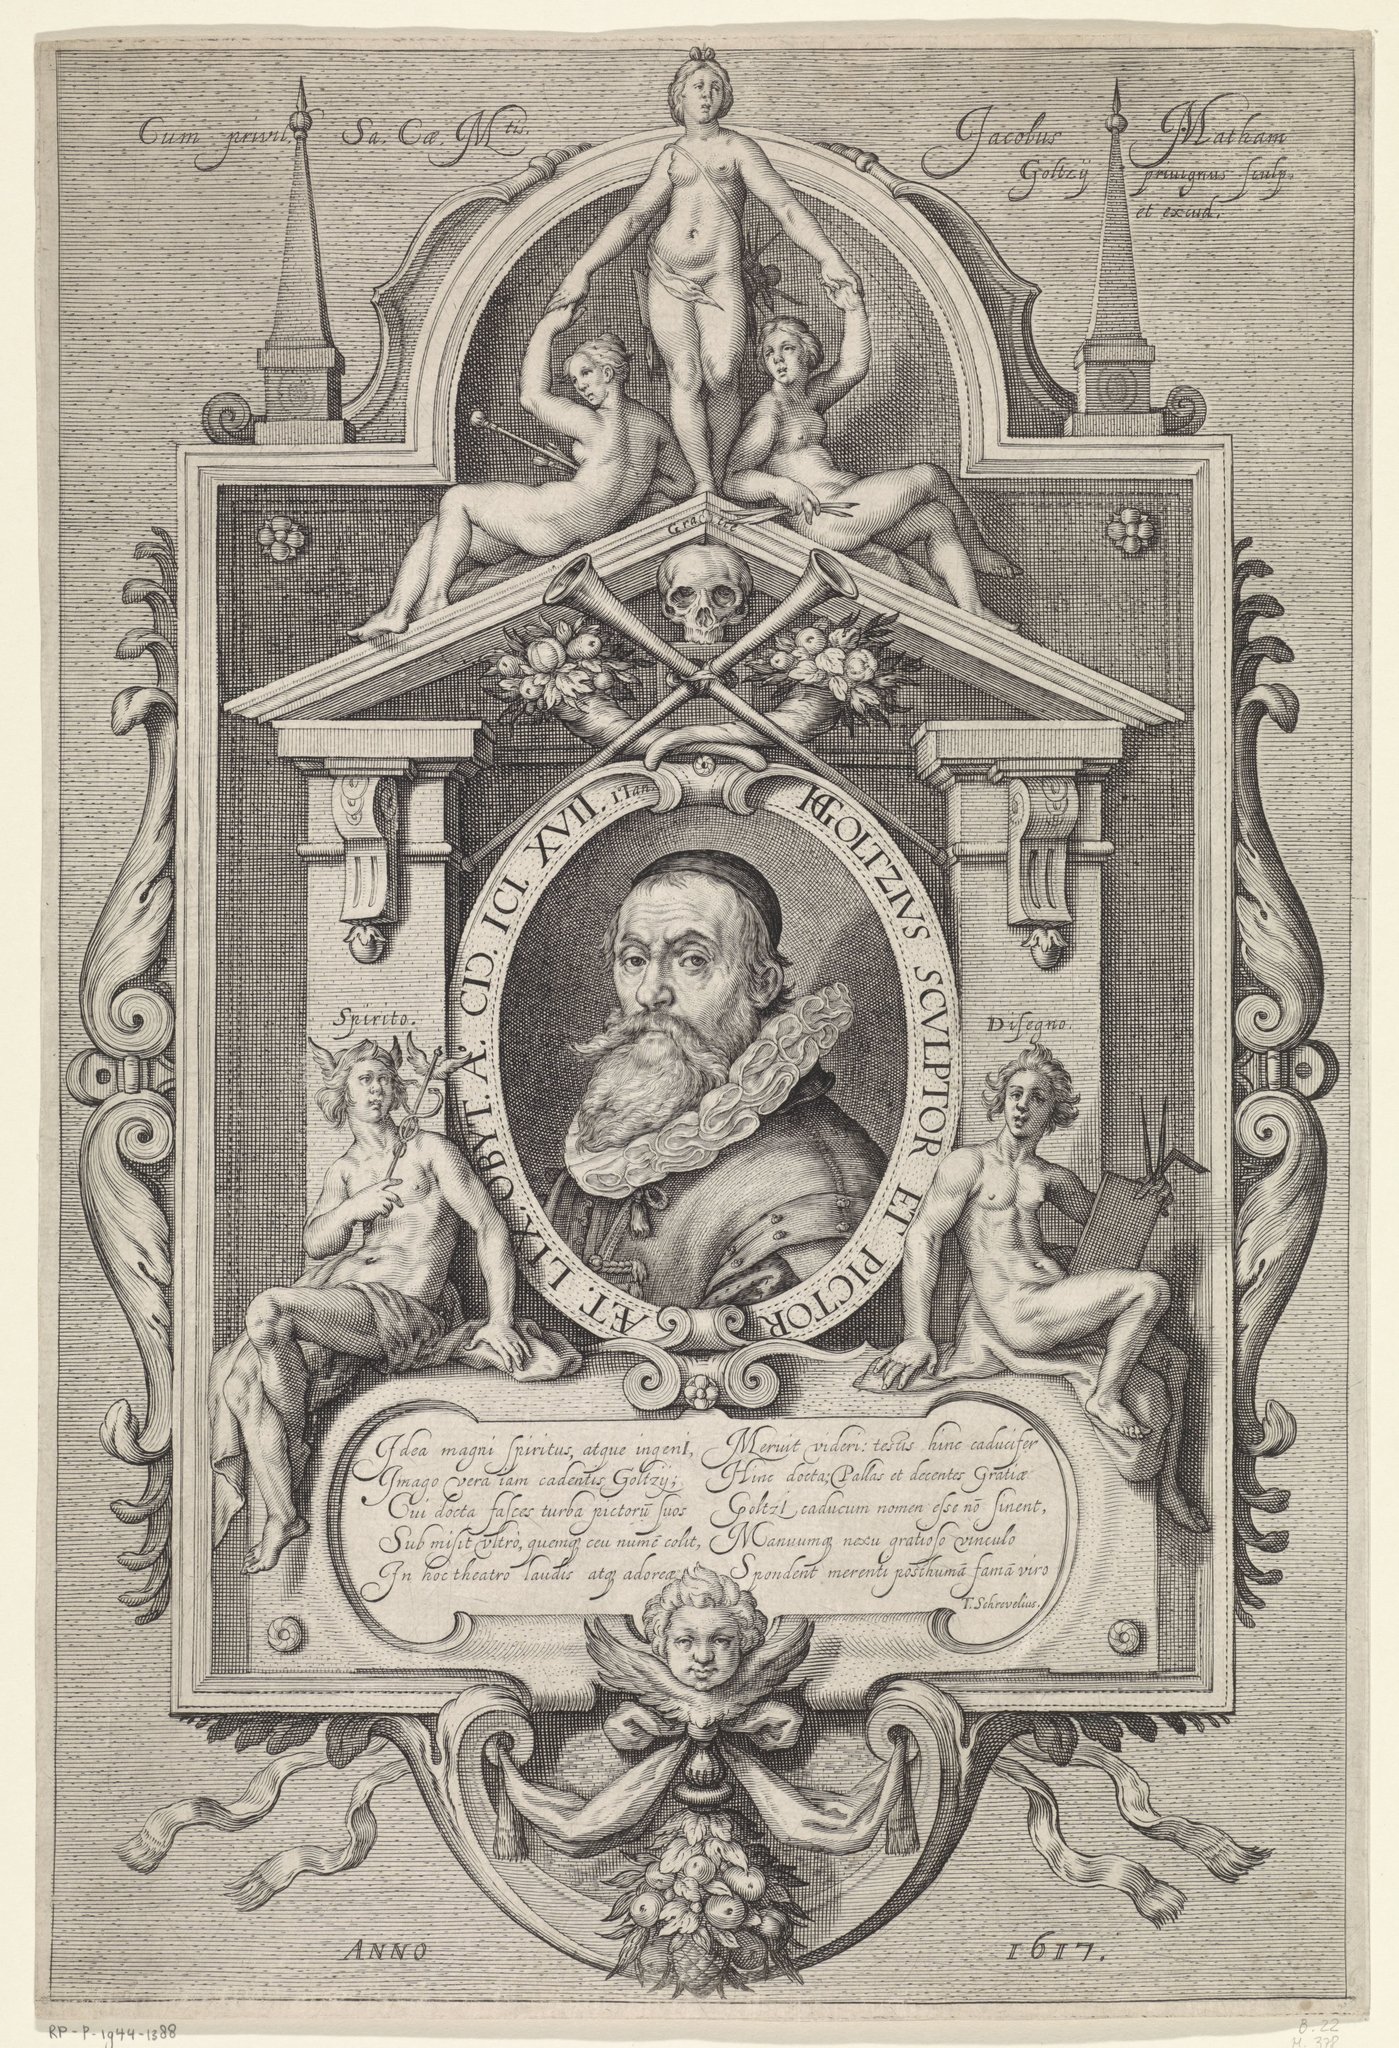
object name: print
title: Portret van Hendrick Goltzius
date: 1617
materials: paper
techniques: engraving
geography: haarlem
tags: haarlem, painter, print maker, draughtsman, hendrick goltzius, idea, concept; 'idea' (ripa), 'cornucopia', horn of plenty, historical persons, graces (charites), generally three in number; 'gratie' (ripa), portrait, self-portrait of painter, skull as symbol of 'vanitas', honouring the artist, ornament derived from architectural details, symbolic representations, allegories and emblems ~ drawing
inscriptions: inscription: ‘HGOLTZIUS SCULPTOR ET PICTOR AET. LIX OBYT 1617’, collector's mark: Lugt 2228, date: ‘Anno 1617’, poem: ‘Idea magni...fama viro. T. Schrevelius’, signature and address: ‘Jacob Matham / Goltzij privignus sculp / et excud.’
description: Portret van Hendrick Goltius (1558-1616), schilder en graveur, op 59-jarige leeftijd. Buste naar links, in ovaal. Het ovaal is gevat in een architectonische omlijsting met allegorische figuren die verwijzen naar zijn kunstenaarschap. Links zit 'Spirito' met caduceus, rechts zit 'Disegno' met tekenattributen. Midden boven de drie gratiën. Boven het portret, in het fronton een doodshoofd, twee hoornen des overvloeds en twee bazuinen.